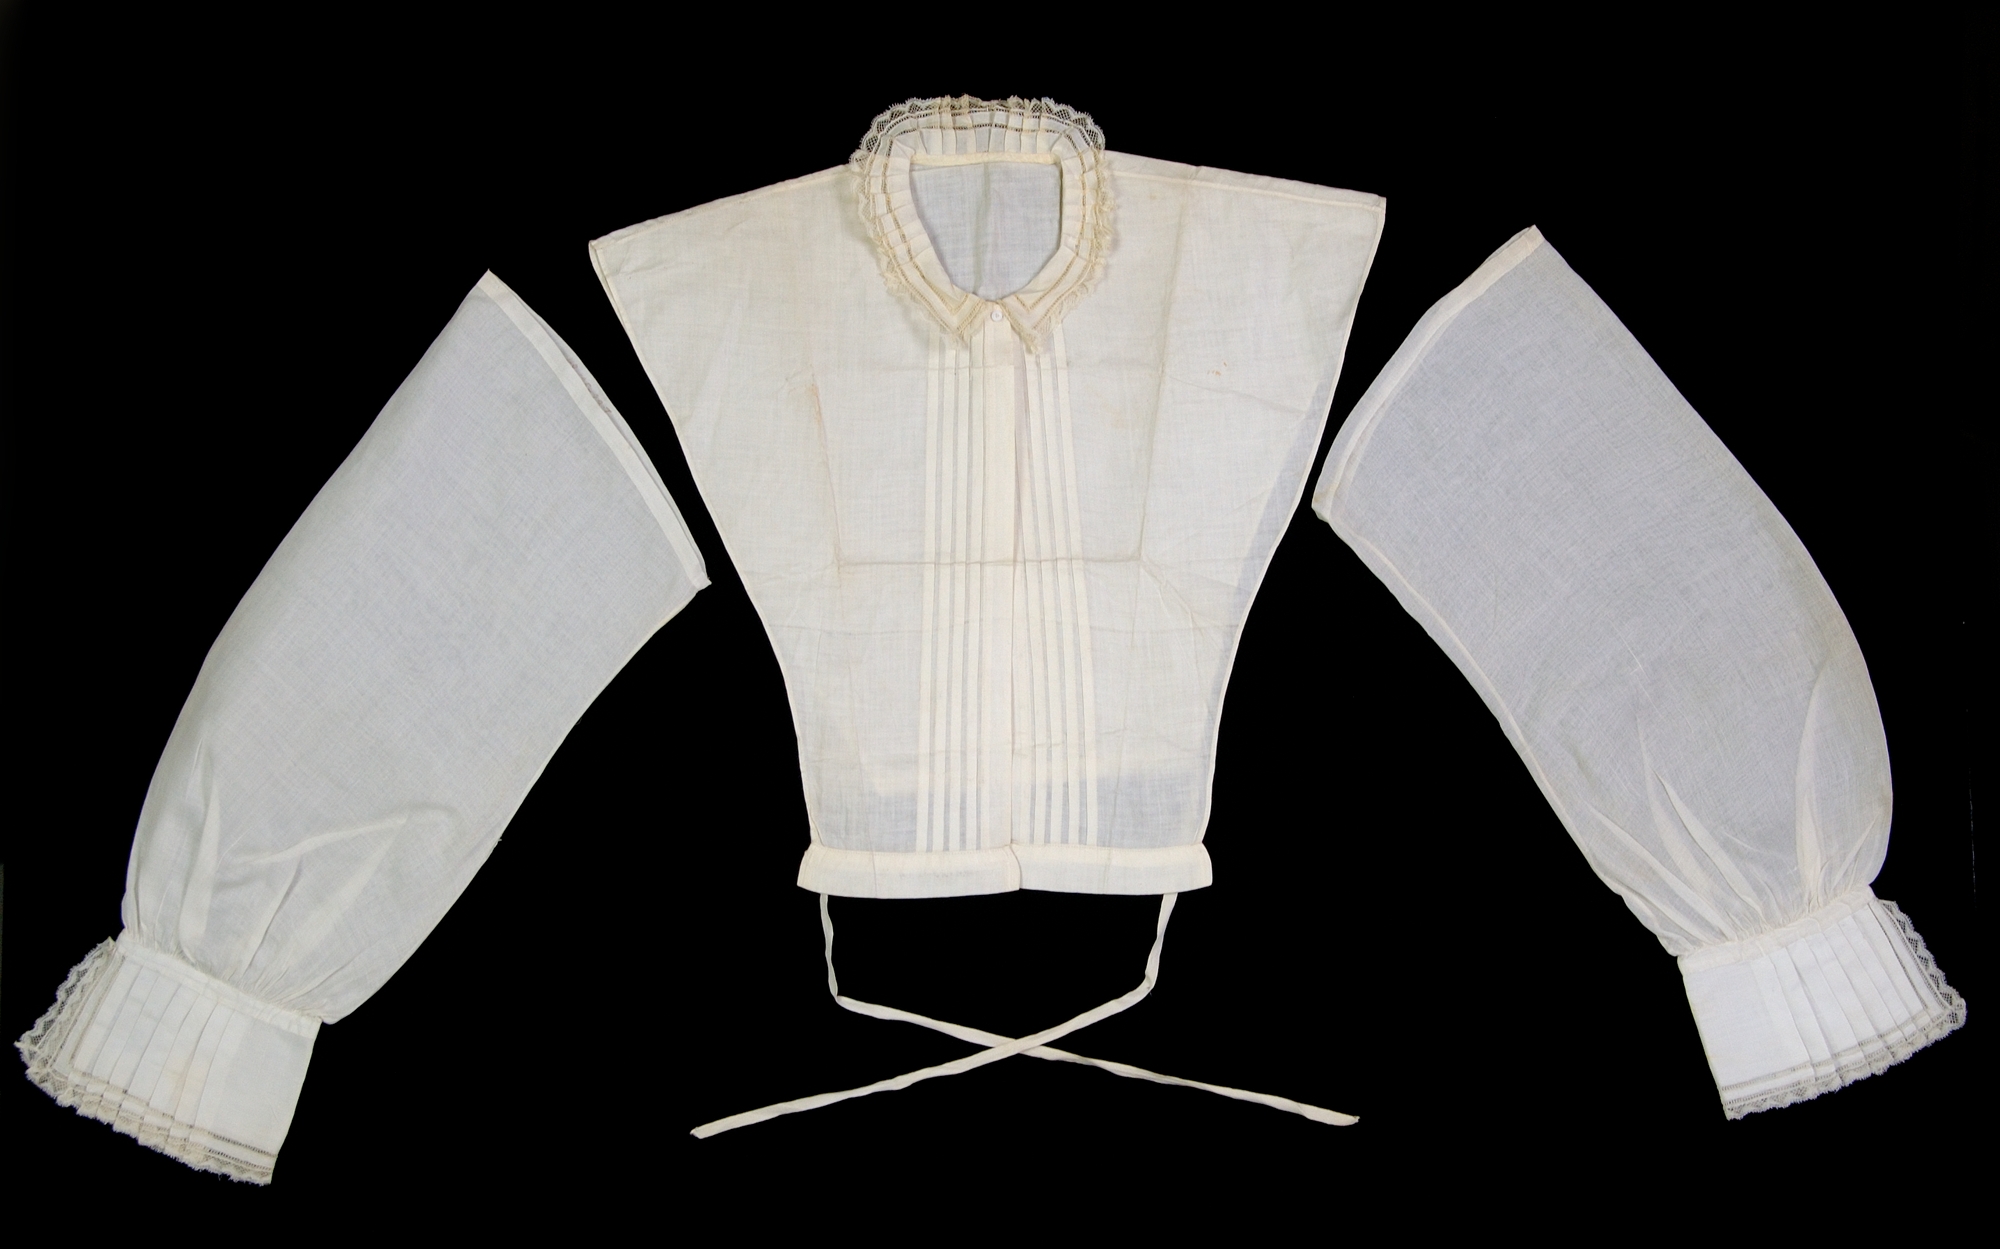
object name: accessory set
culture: american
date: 1870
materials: cotton